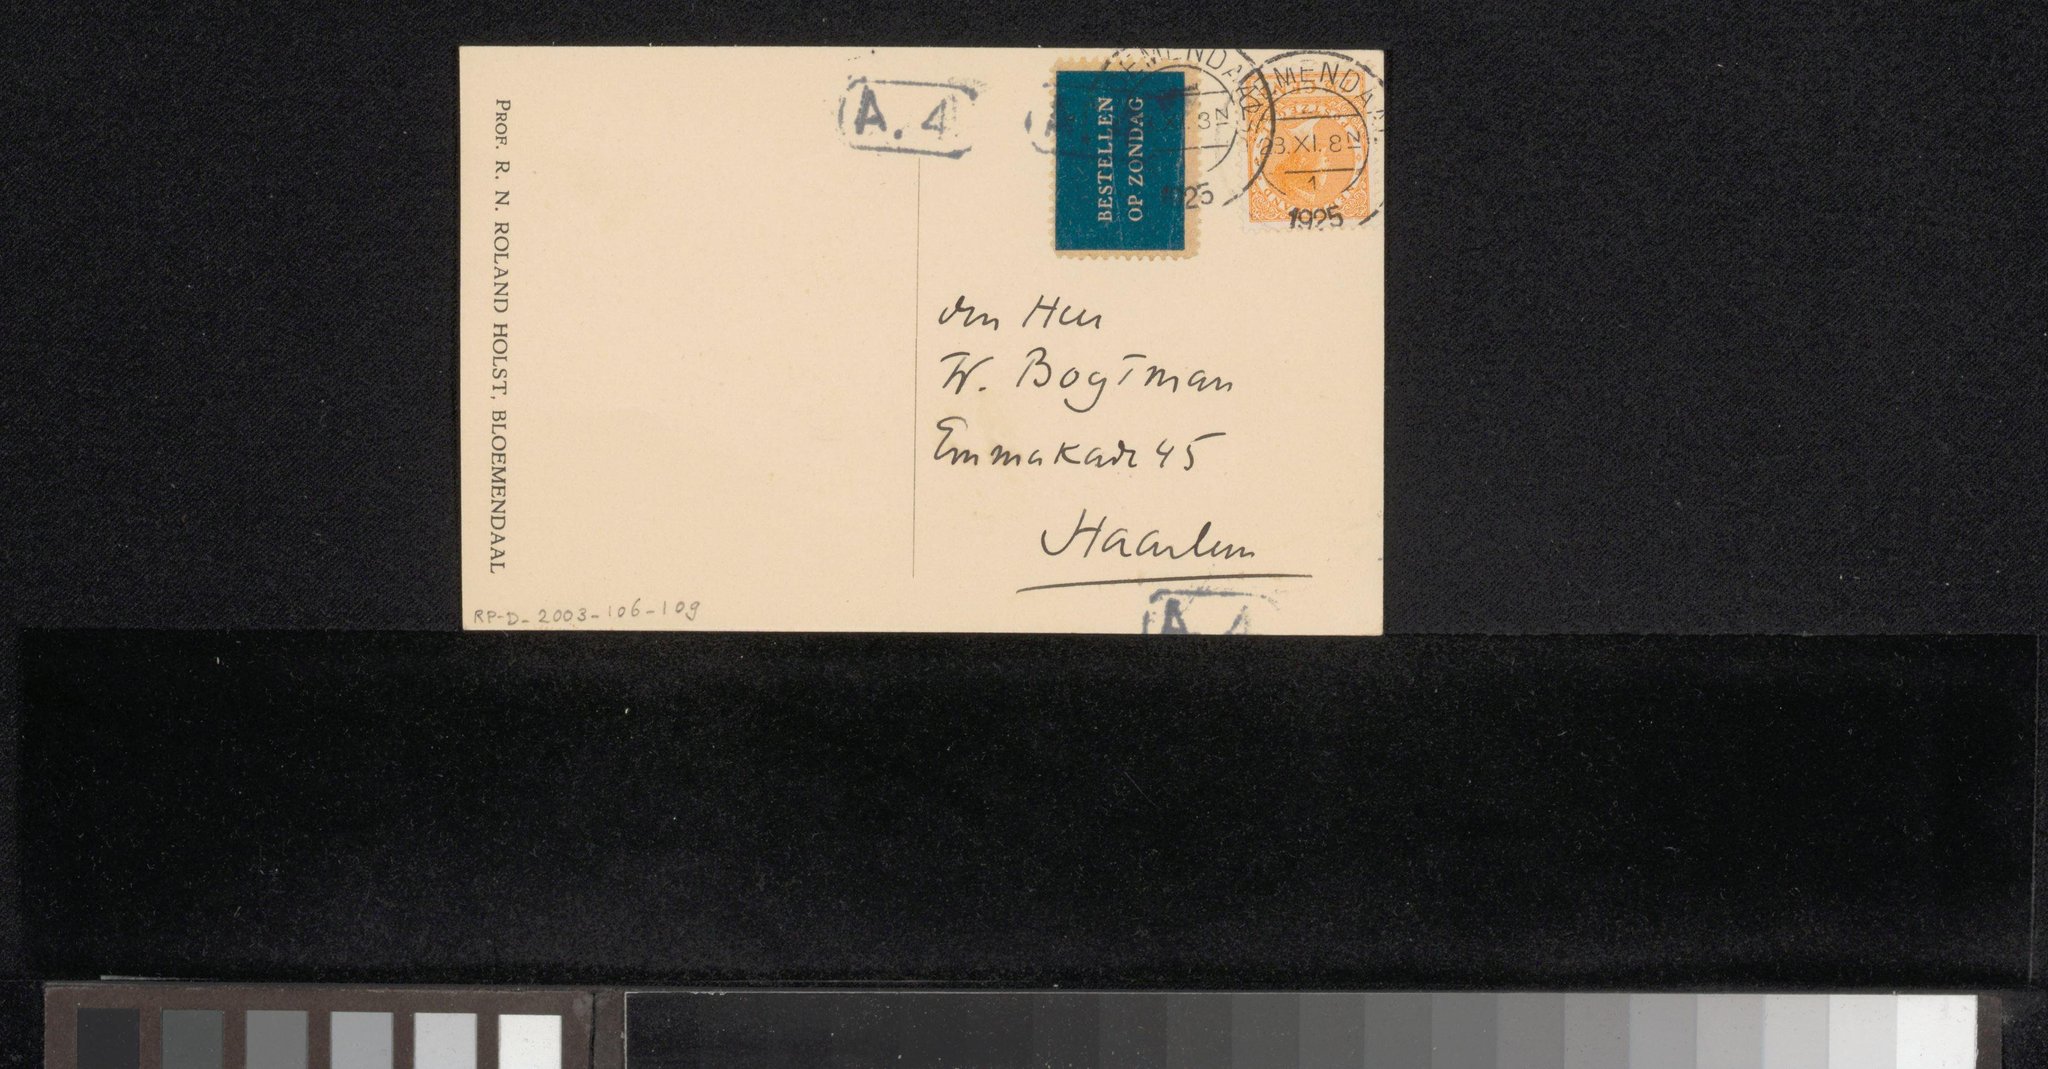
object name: postcard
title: Briefkaart aan Willem Bogtman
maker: richard nicolaüs roland holst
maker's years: 1868-1938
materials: cardboard, ink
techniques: pen, writing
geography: bloemendaal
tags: haarlem, willem bogtman, applied arts, arts and crafts; industrial design, painting (including book-illumination, miniature-painting)